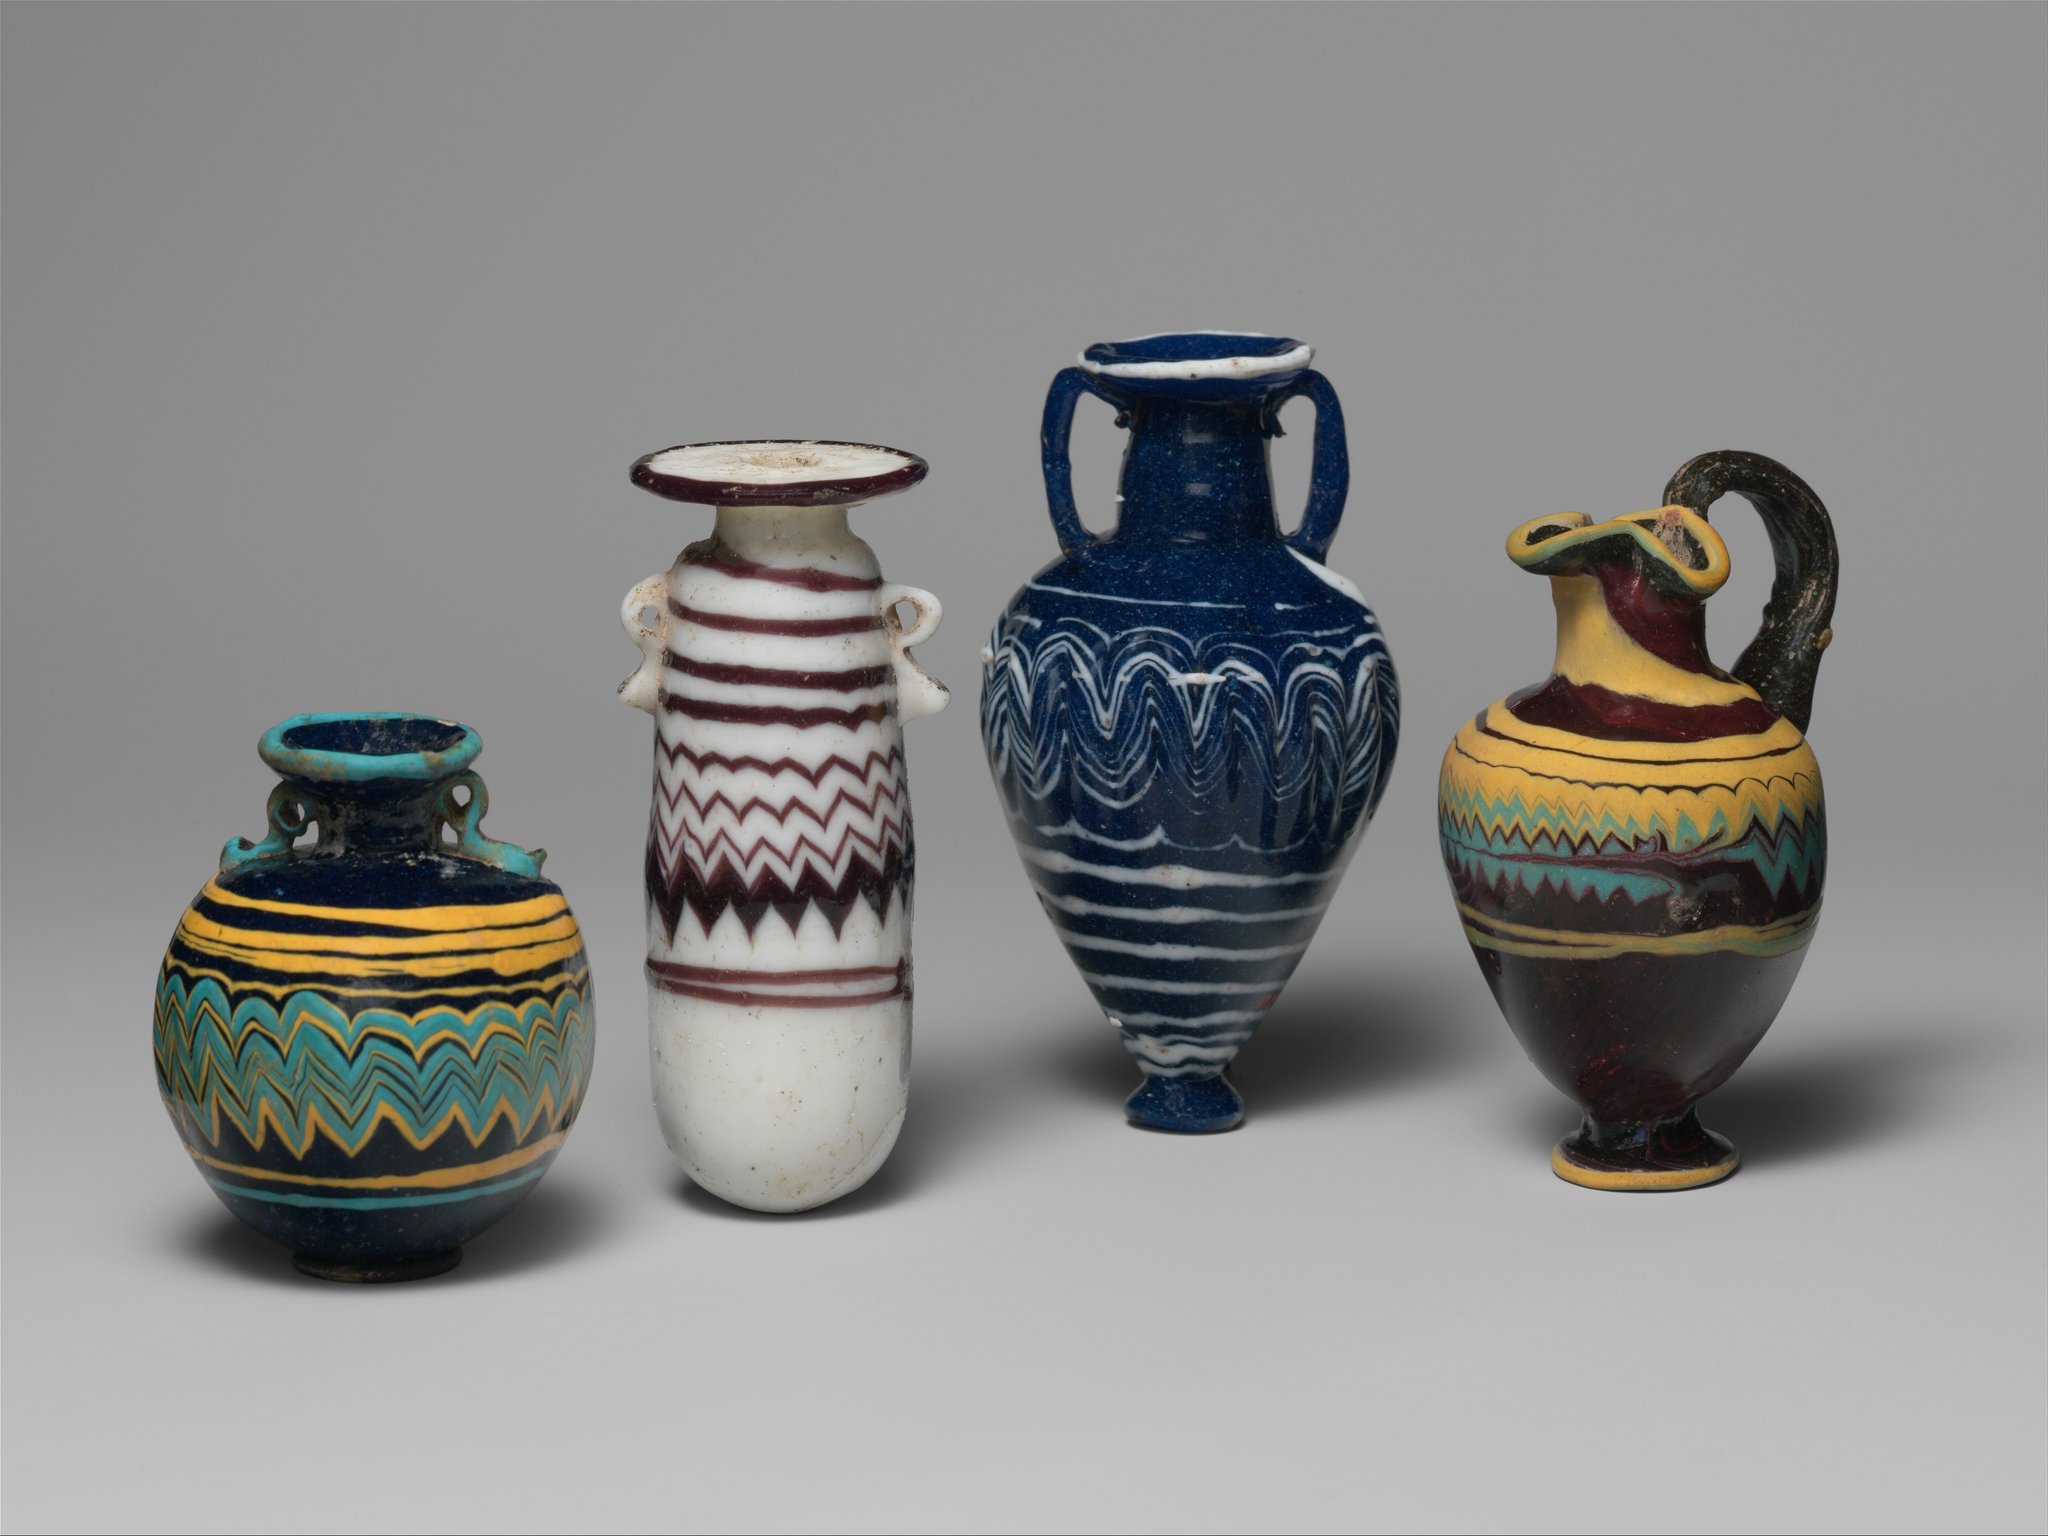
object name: alabastron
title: Glass alabastron (perfume bottle)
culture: greek, eastern mediterranean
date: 534-401 BCE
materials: glass